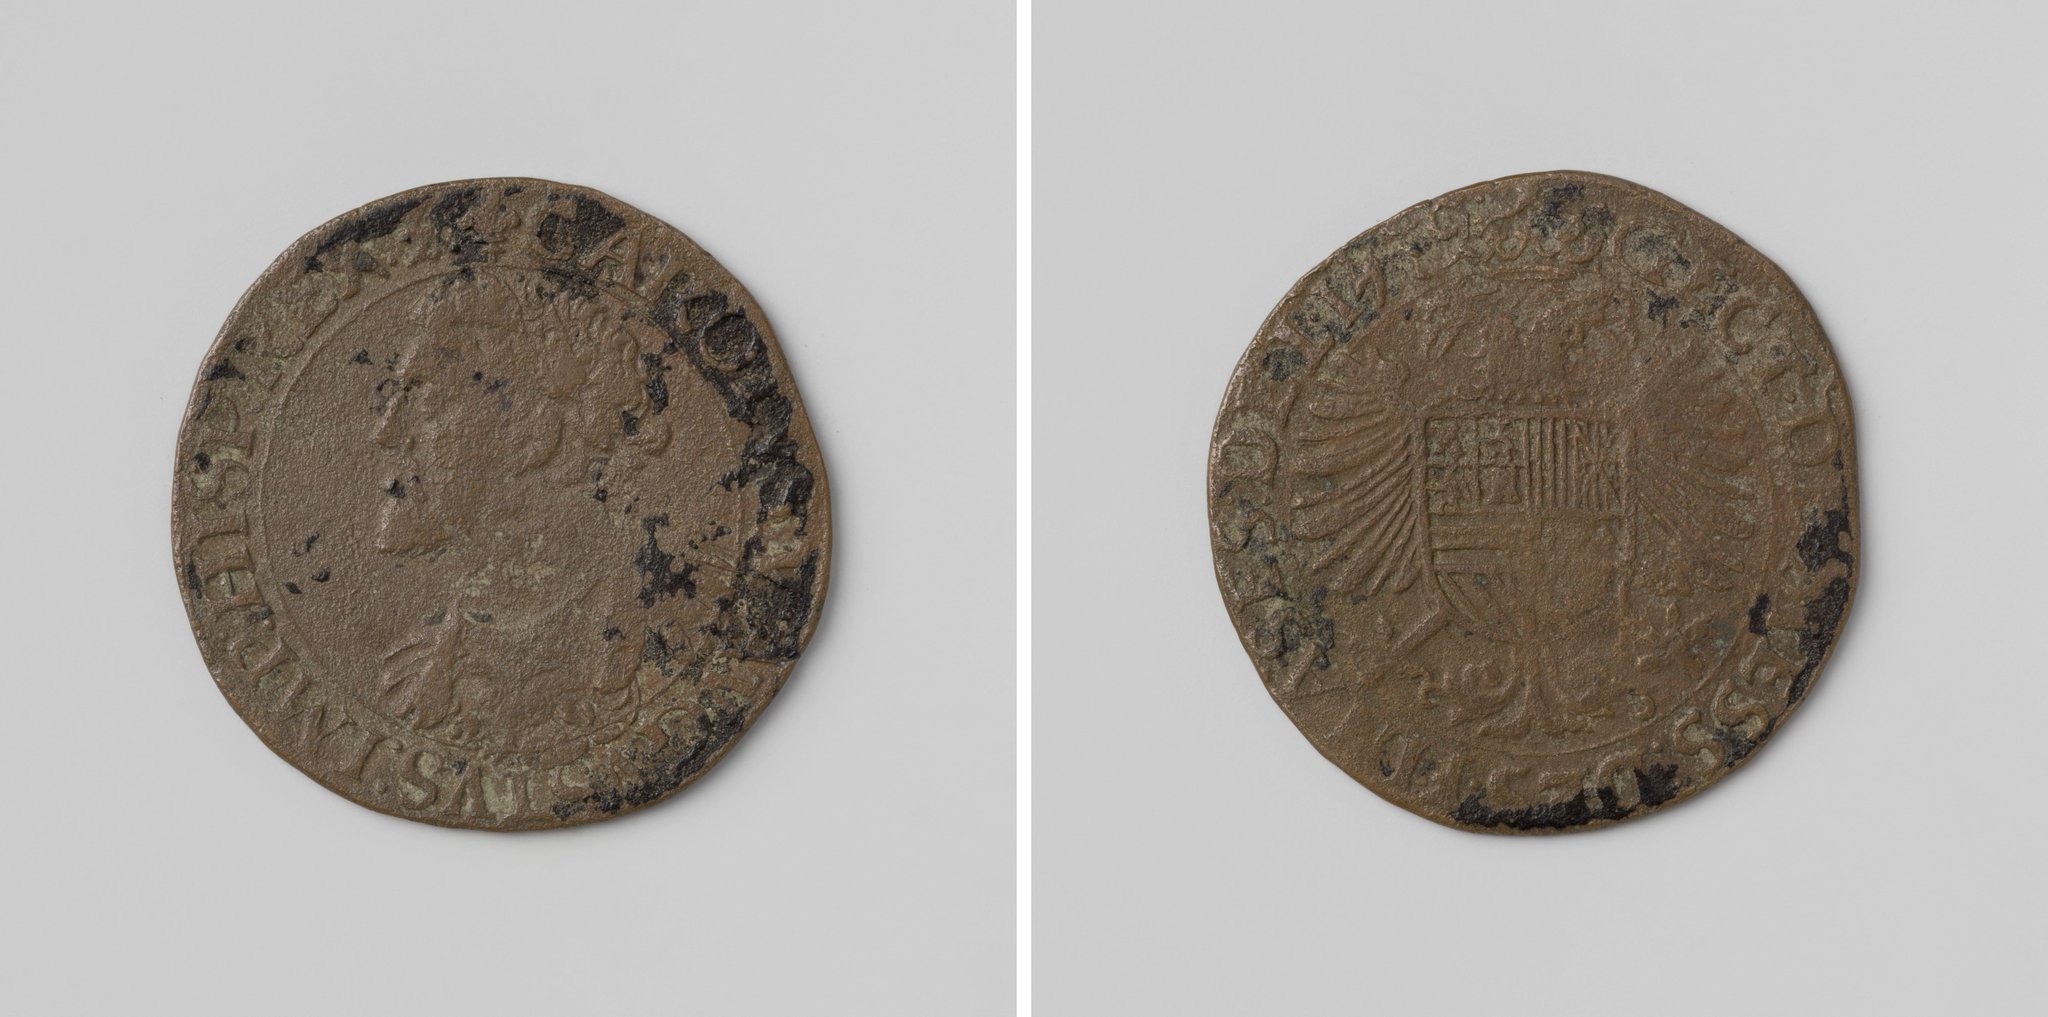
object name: jeton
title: Karel V, Duits keizer, rekenpenning van de raad van Financien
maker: Anonymous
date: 1539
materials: copper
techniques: striking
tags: ghent, charles v (holy roman emperor and king of spain)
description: Koperen penning. Voorzijde: borststuk man met lauwerkrans binnen omschrift. Keerzijde: tweekoppige adelaar onder kroon met wapenschild binnen omschrift